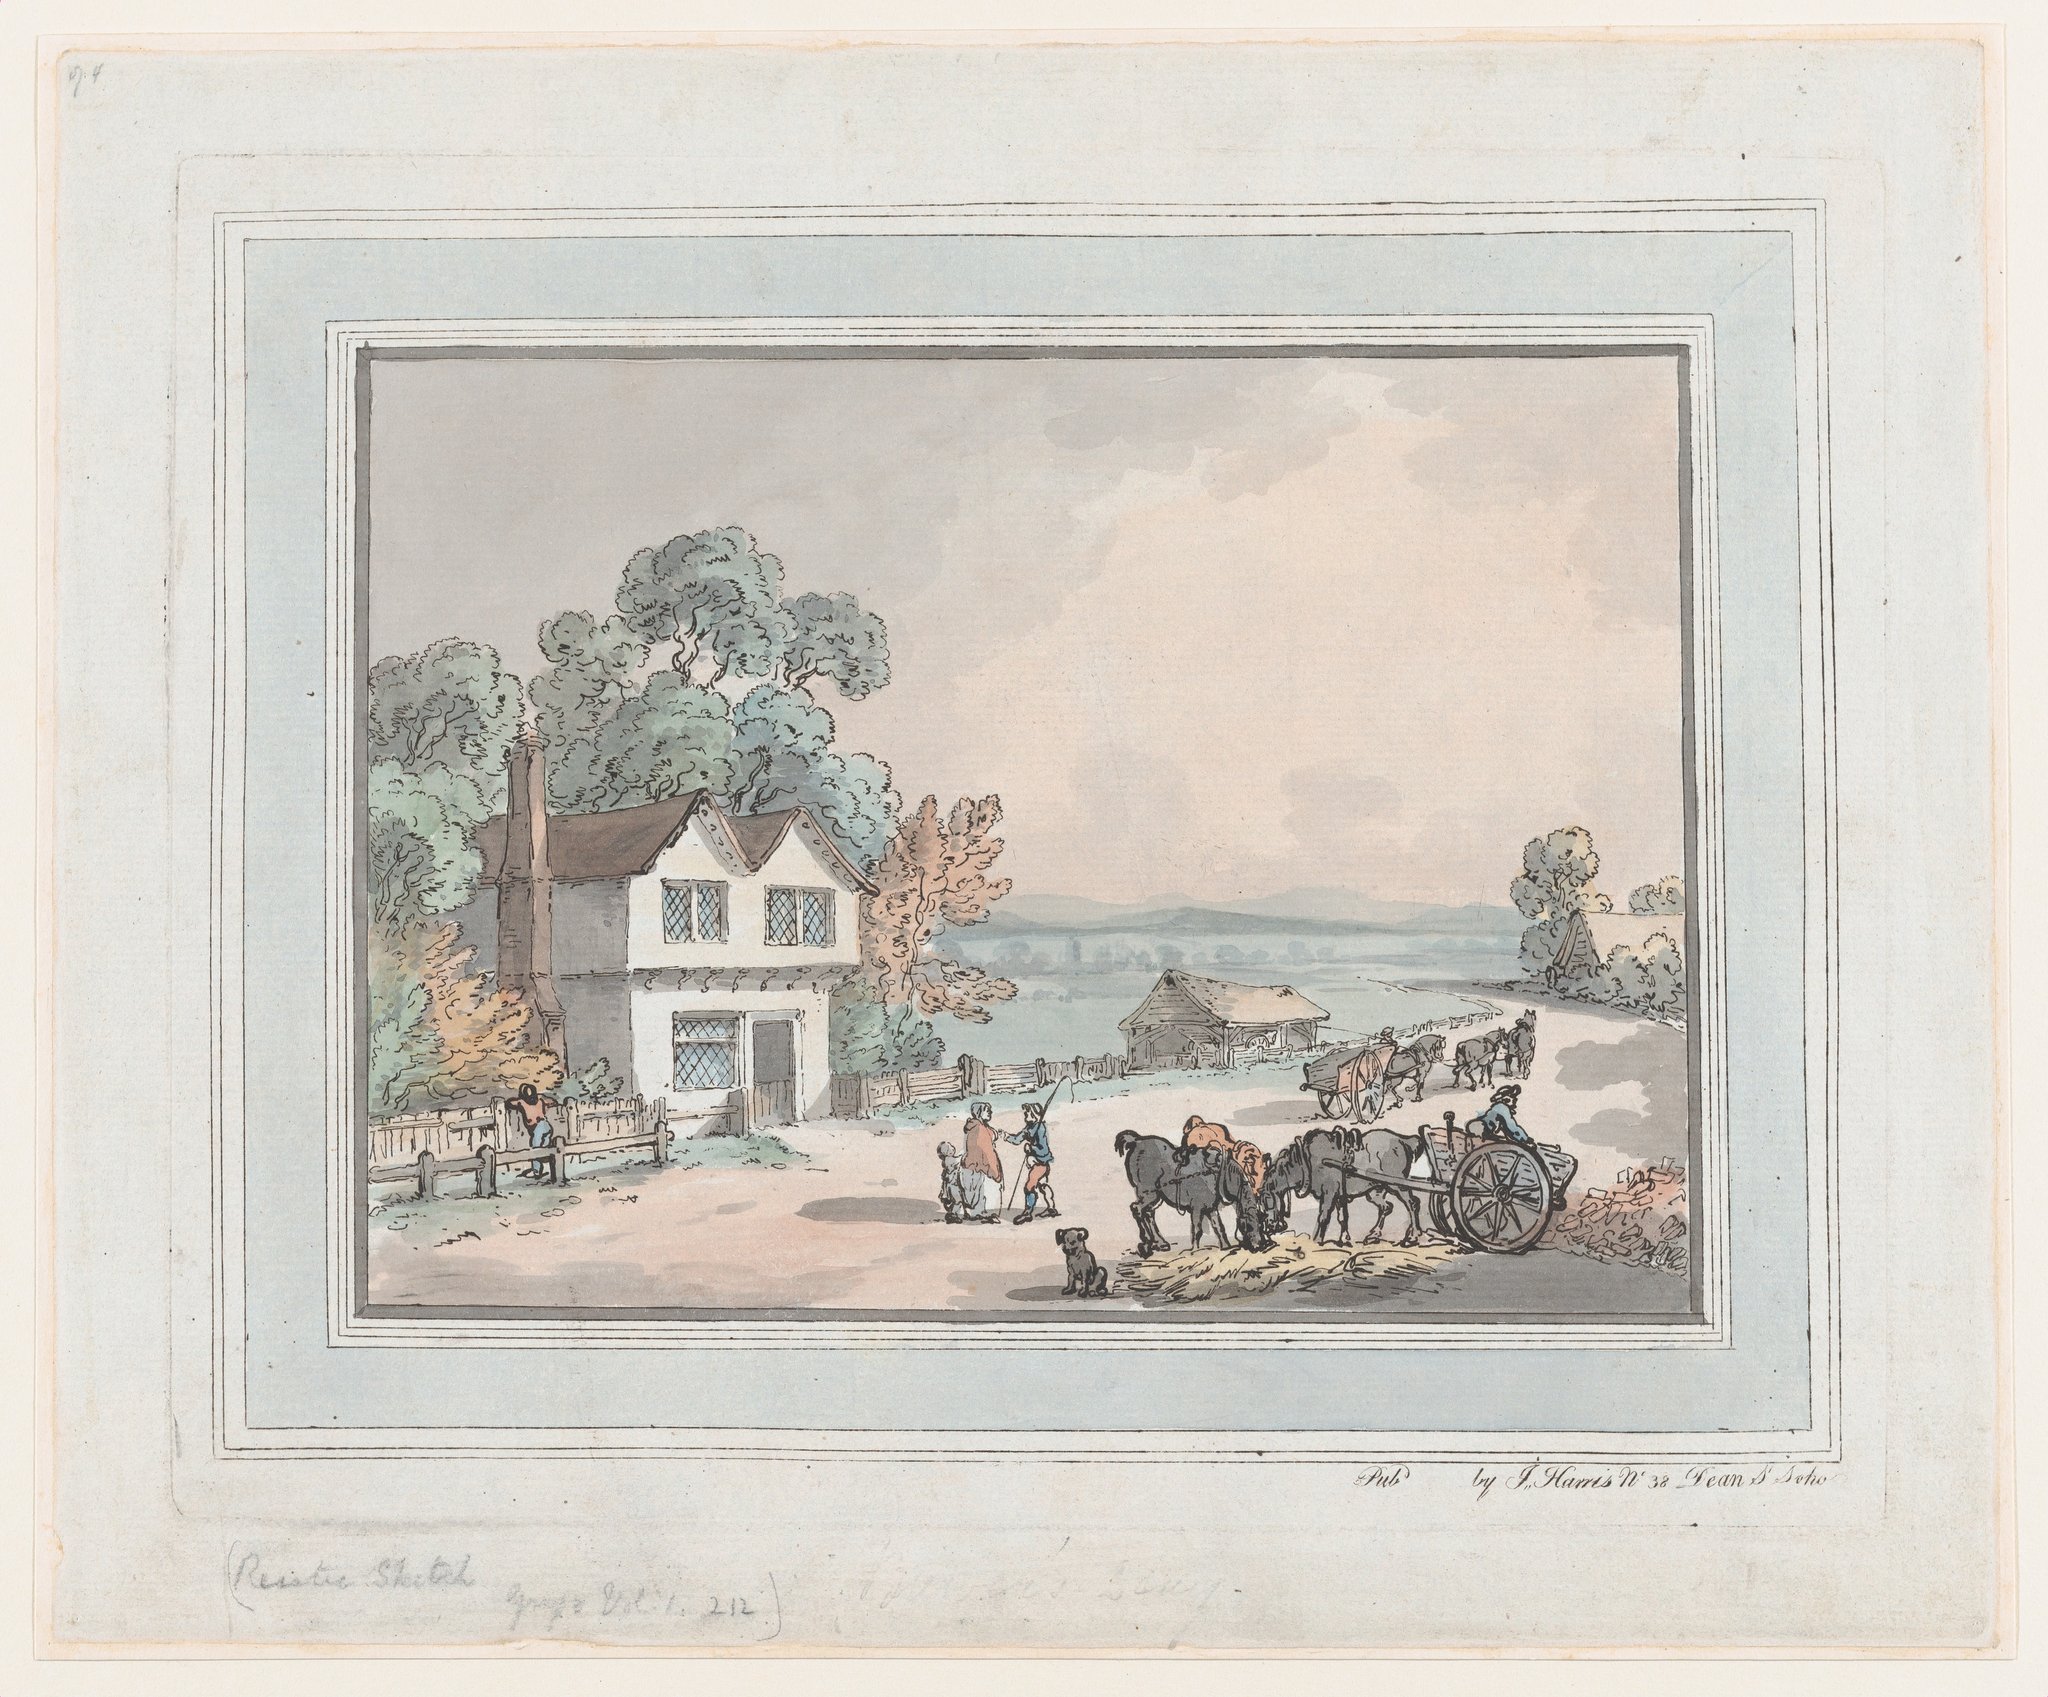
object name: print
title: Rustic Sketch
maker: thomas rowlandson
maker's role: artist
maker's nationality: british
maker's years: 1757-1827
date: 1787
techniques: aquatint, etching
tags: houses,roads,horses,carriages